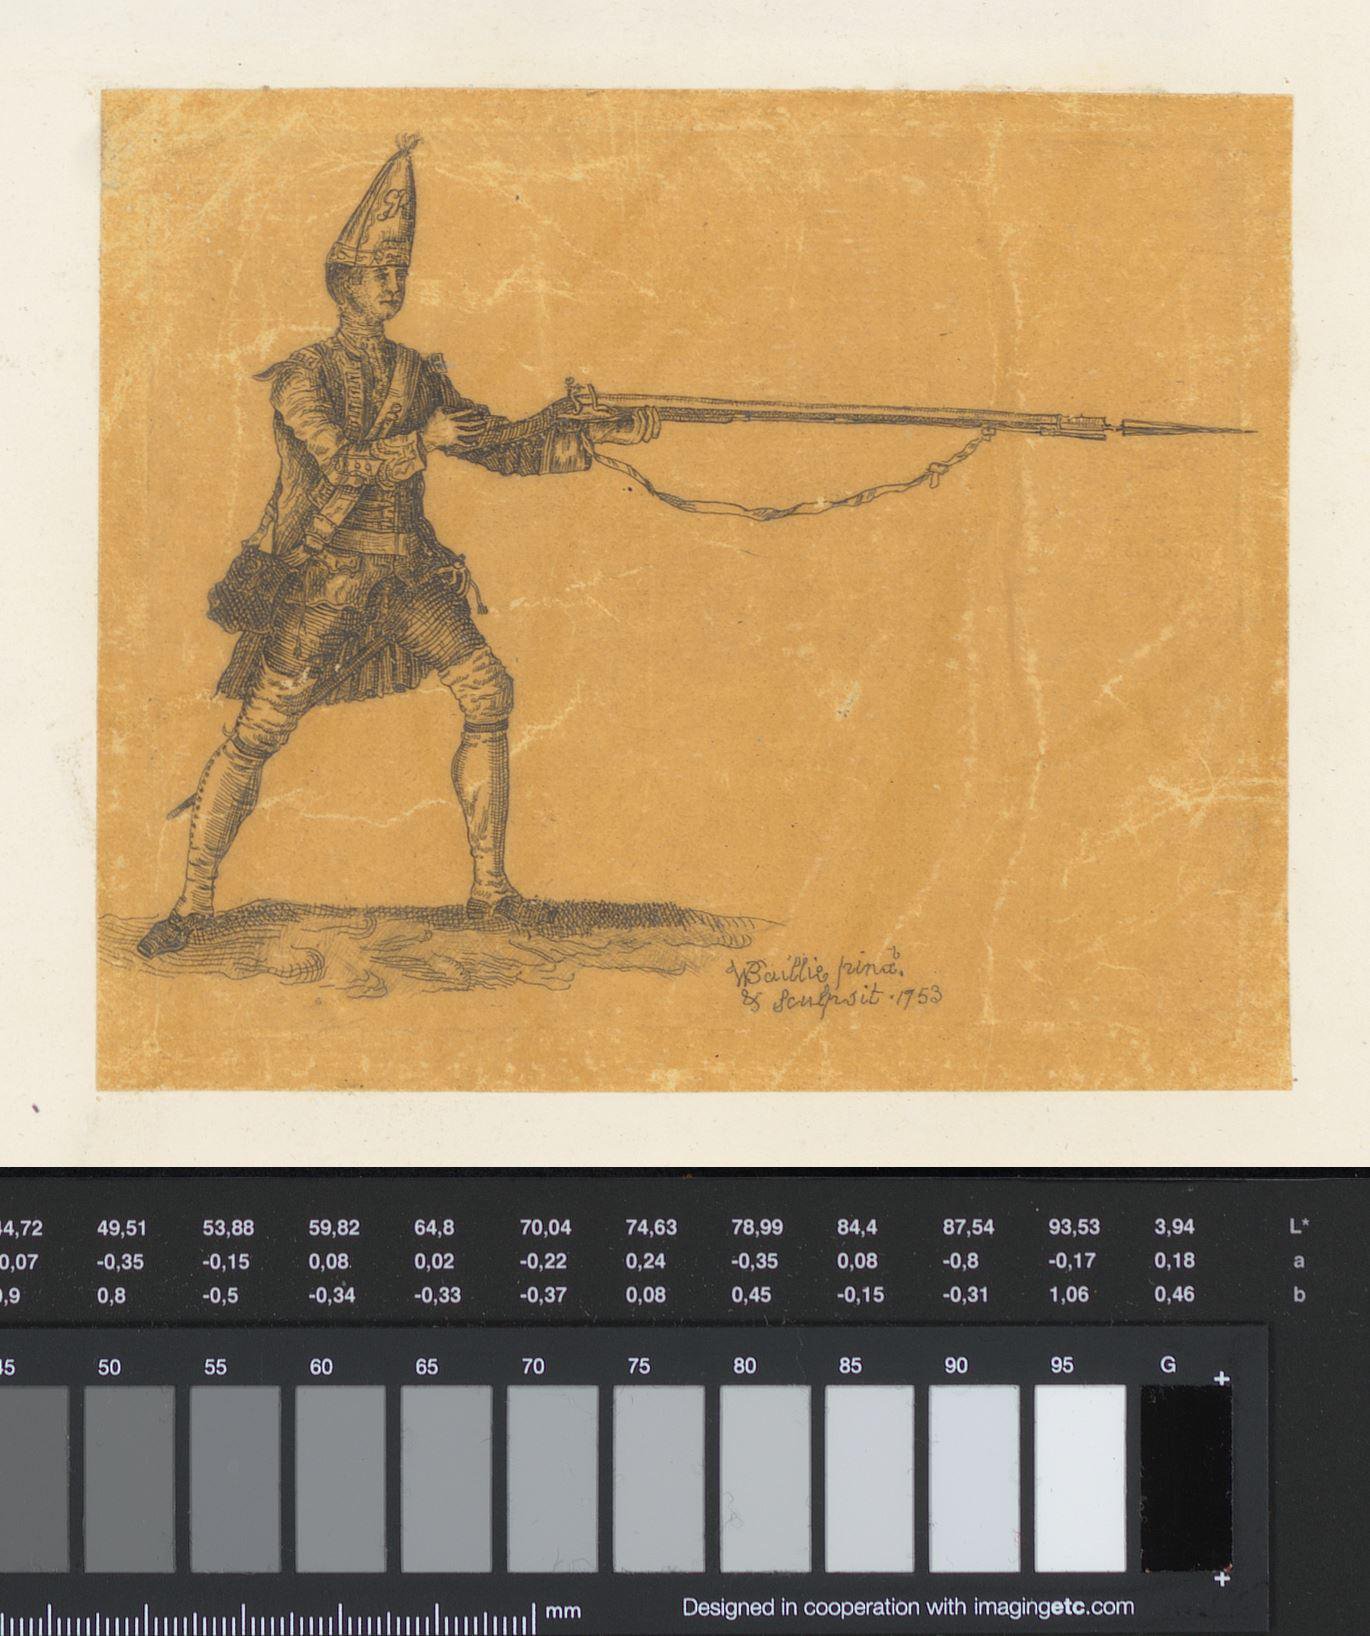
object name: album leaf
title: Soldaat met bajonet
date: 1753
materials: paper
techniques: etching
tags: helved weapons, polearms (for striking, hacking, thrusting) (with name), ranks in the army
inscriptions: stamp